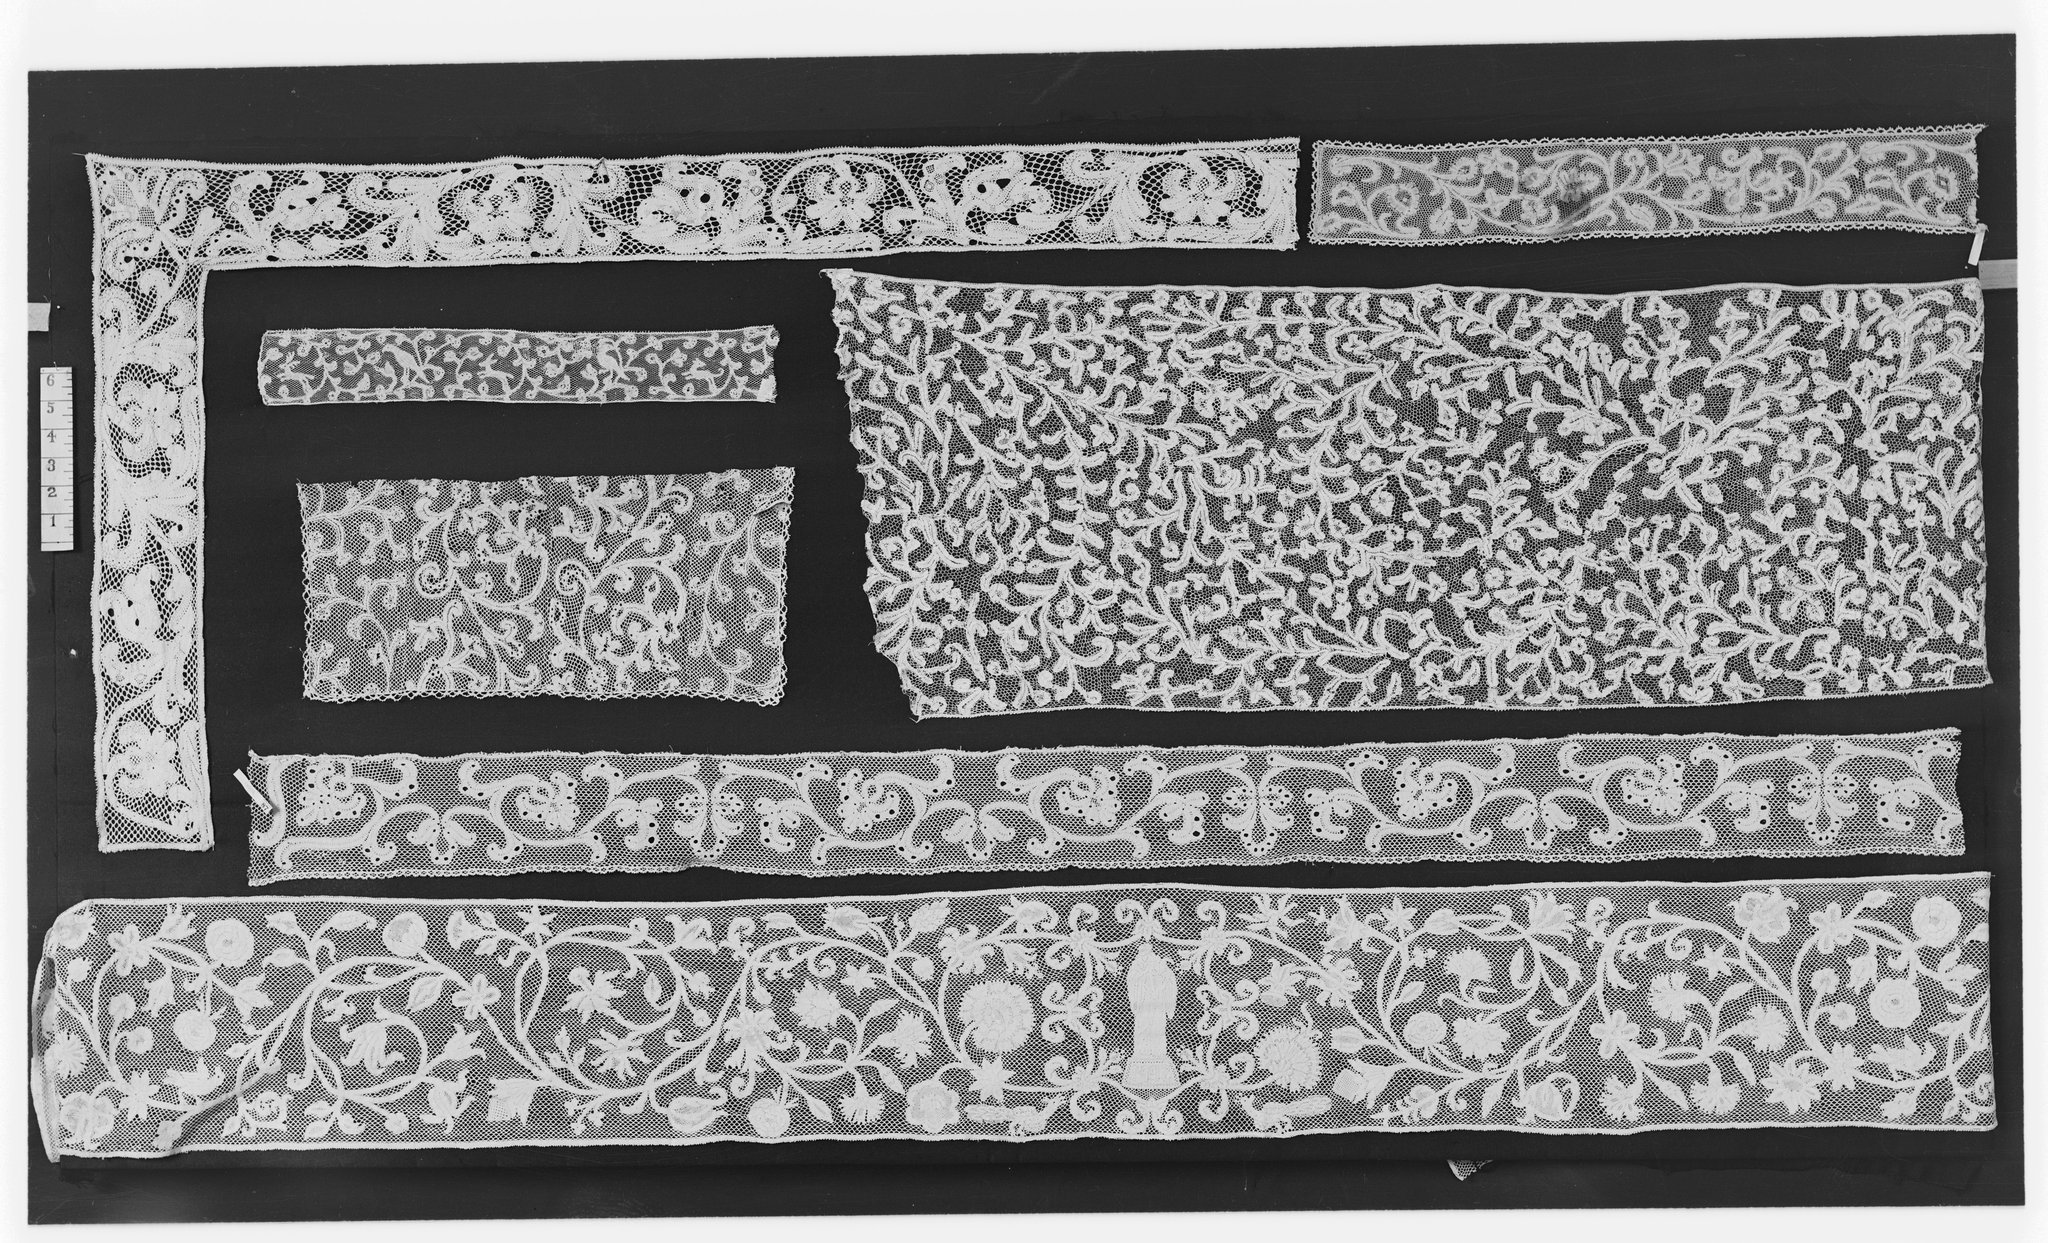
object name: fragment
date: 1667-1700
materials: lace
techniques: lace